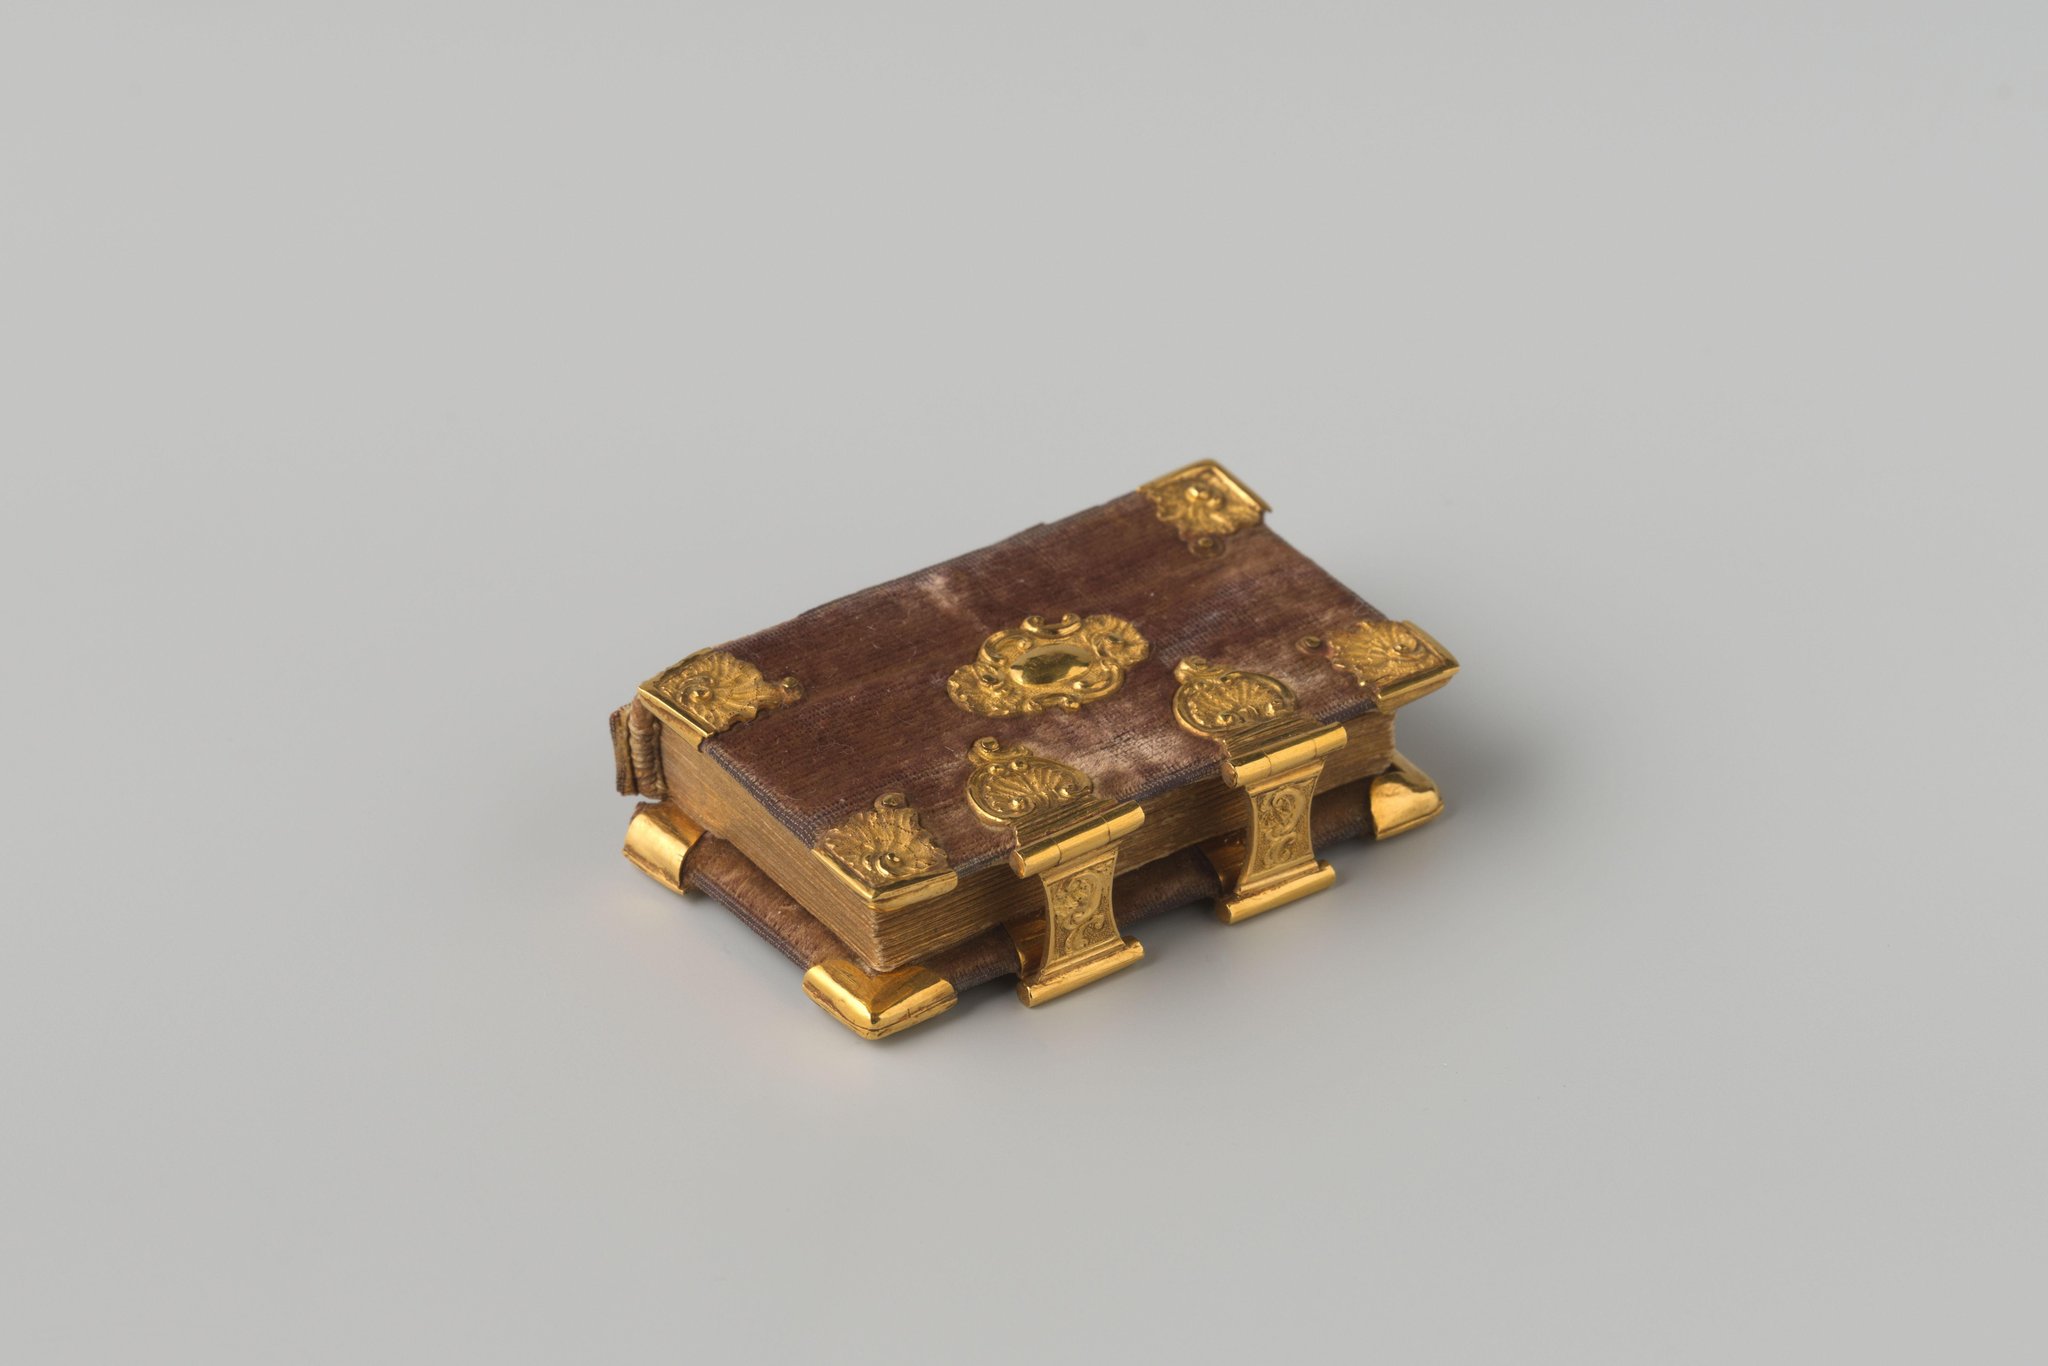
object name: miniature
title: Boek getiteld Kern der Bijbels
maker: dirk fortman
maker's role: goldsmith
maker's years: -1792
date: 1750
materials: gold, paper, silk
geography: the hague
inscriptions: date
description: Boek, gebonden in bruin zijden fluweel met gouden sluiting middenplaat en hoekbeslag, versierd met rocaille motieven; snede verguld, schutbladen van roze zijde. Miniatuur boekje uitgegeven in Den Haag bij A. de Groot en Zoonen. MDCCL (1750). Tien katernen van vier bladen, Tachtig pagina's.